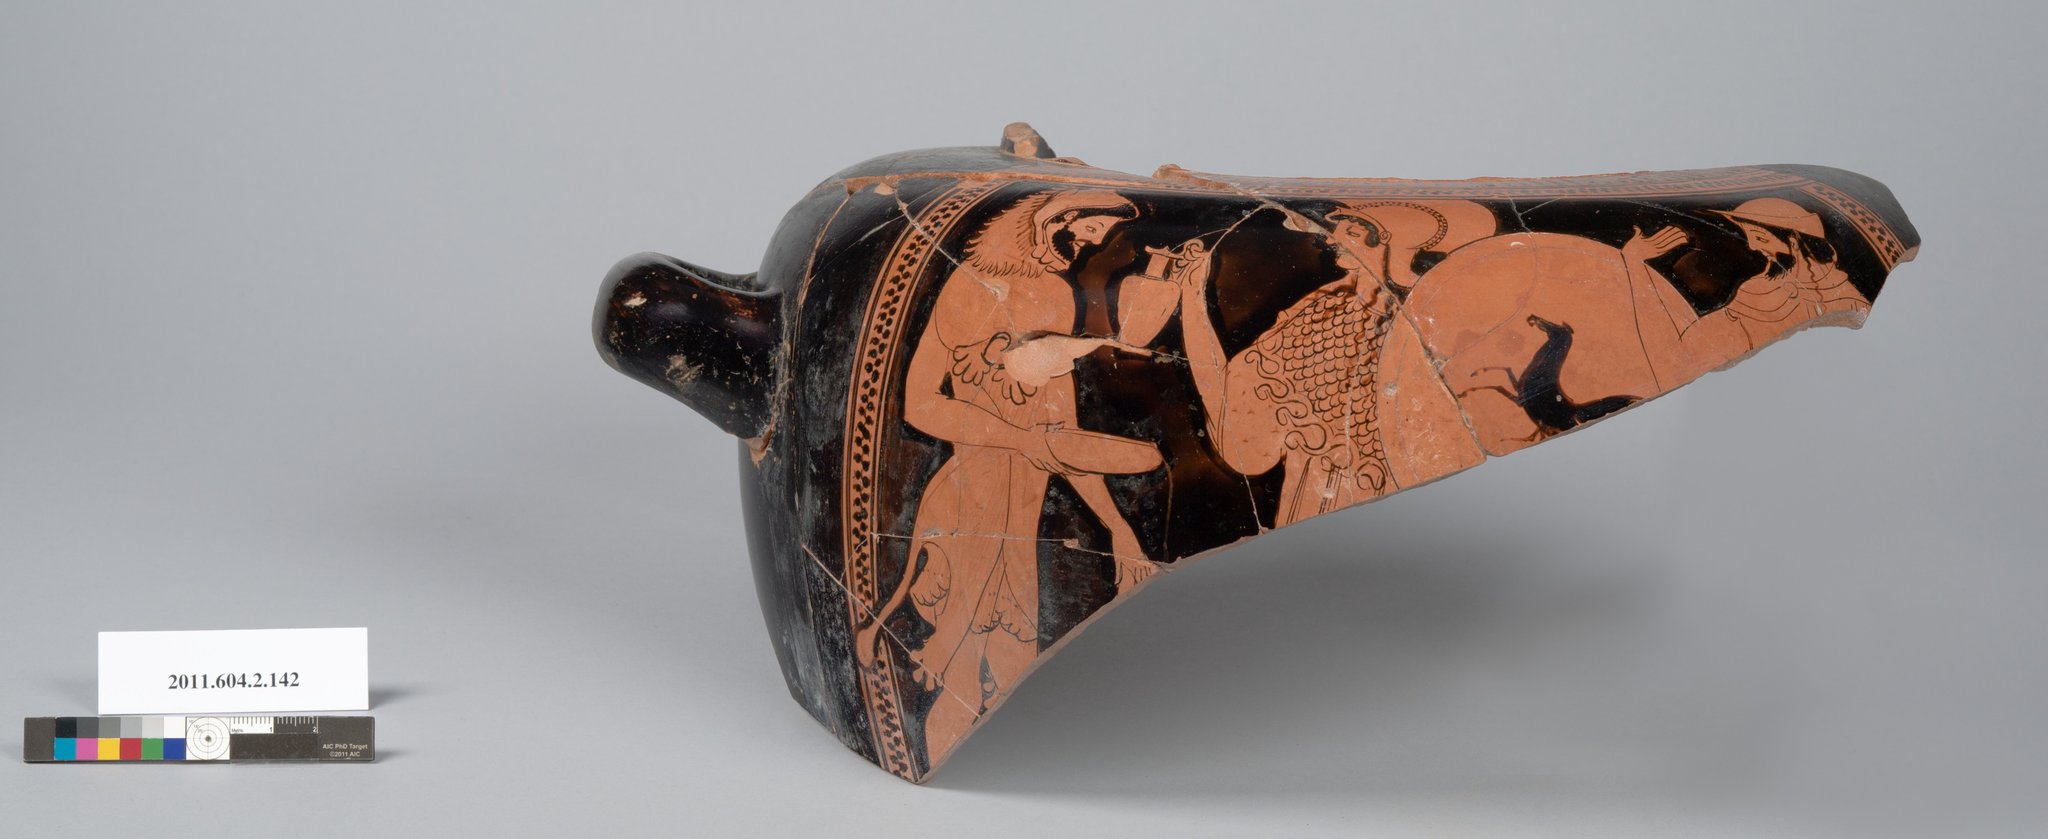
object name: stamnos fragment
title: Terracotta fragment of a stamnos (jar)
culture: greek, attic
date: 500-480 BCE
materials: terracotta